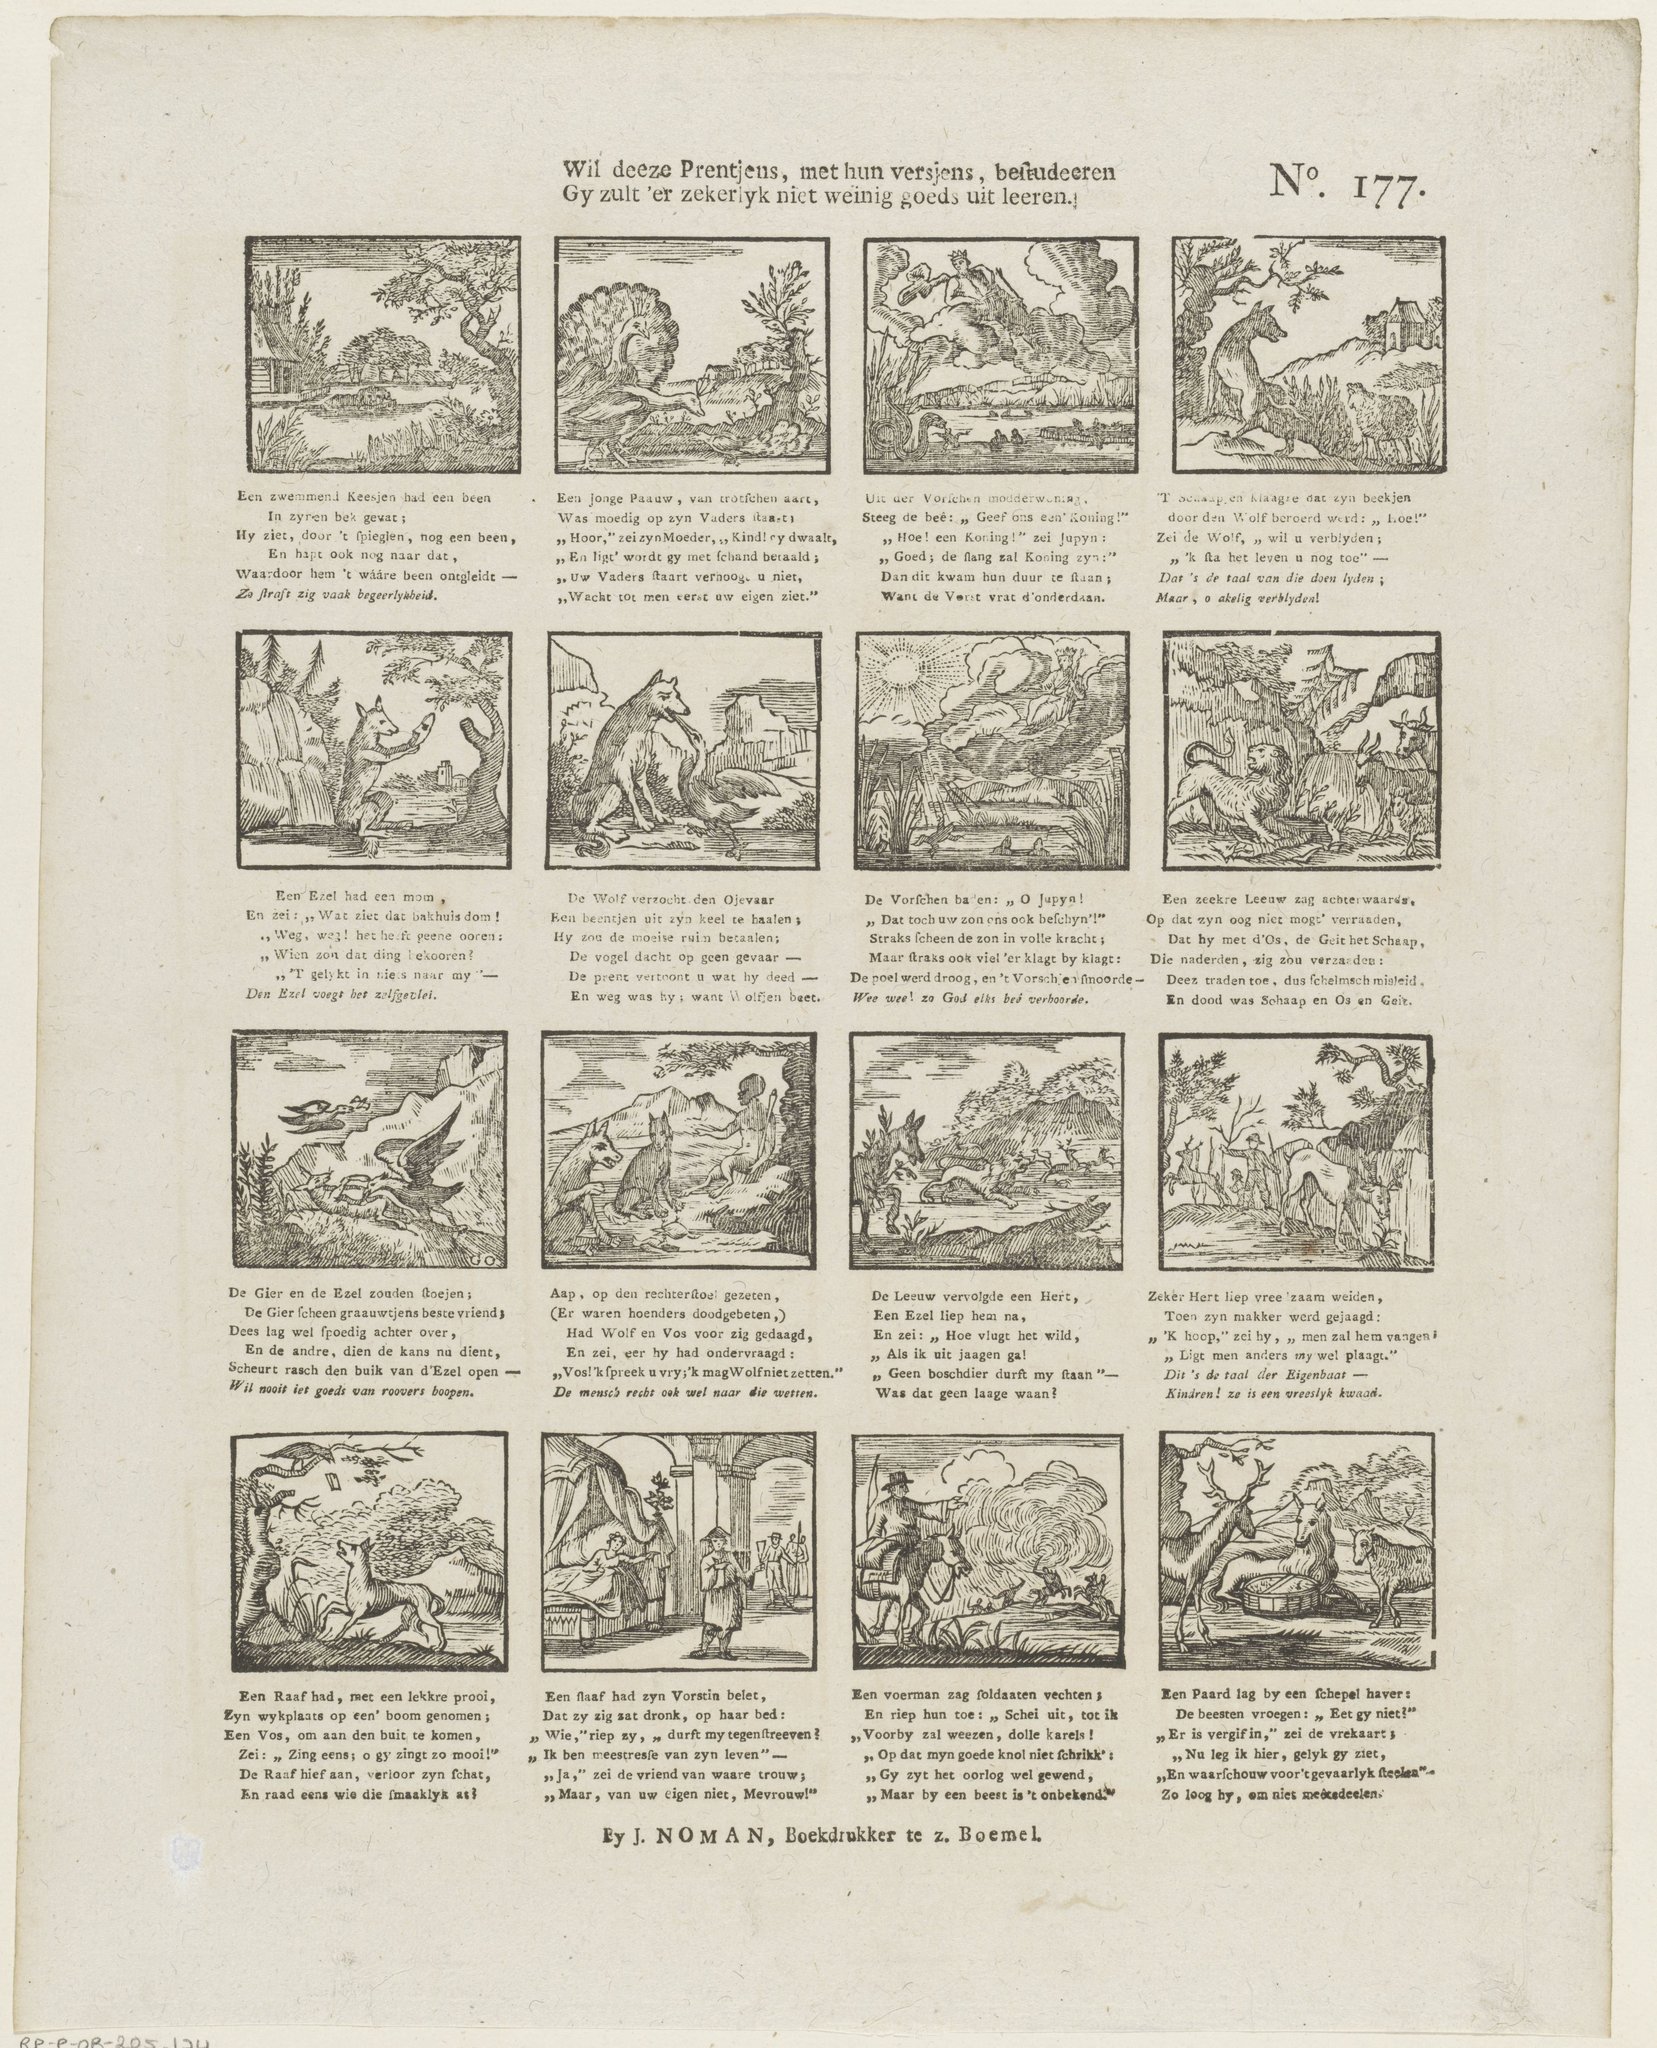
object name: popular print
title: Wil deeze prentjens, met hun versjens, bestudeeren / Gy zult 'er zekerlyk niet weinig goeds uit leeren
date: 1806-1830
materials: paper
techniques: letterpress printing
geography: netherlands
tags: animals, fables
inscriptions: collector's mark: Lugt 2760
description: Blad met 16 voorstellingen uit de fabelen van Aesopus. Onder elke afbeelding een zesregelig vers. Genummerd rechtsboven: No. 177.